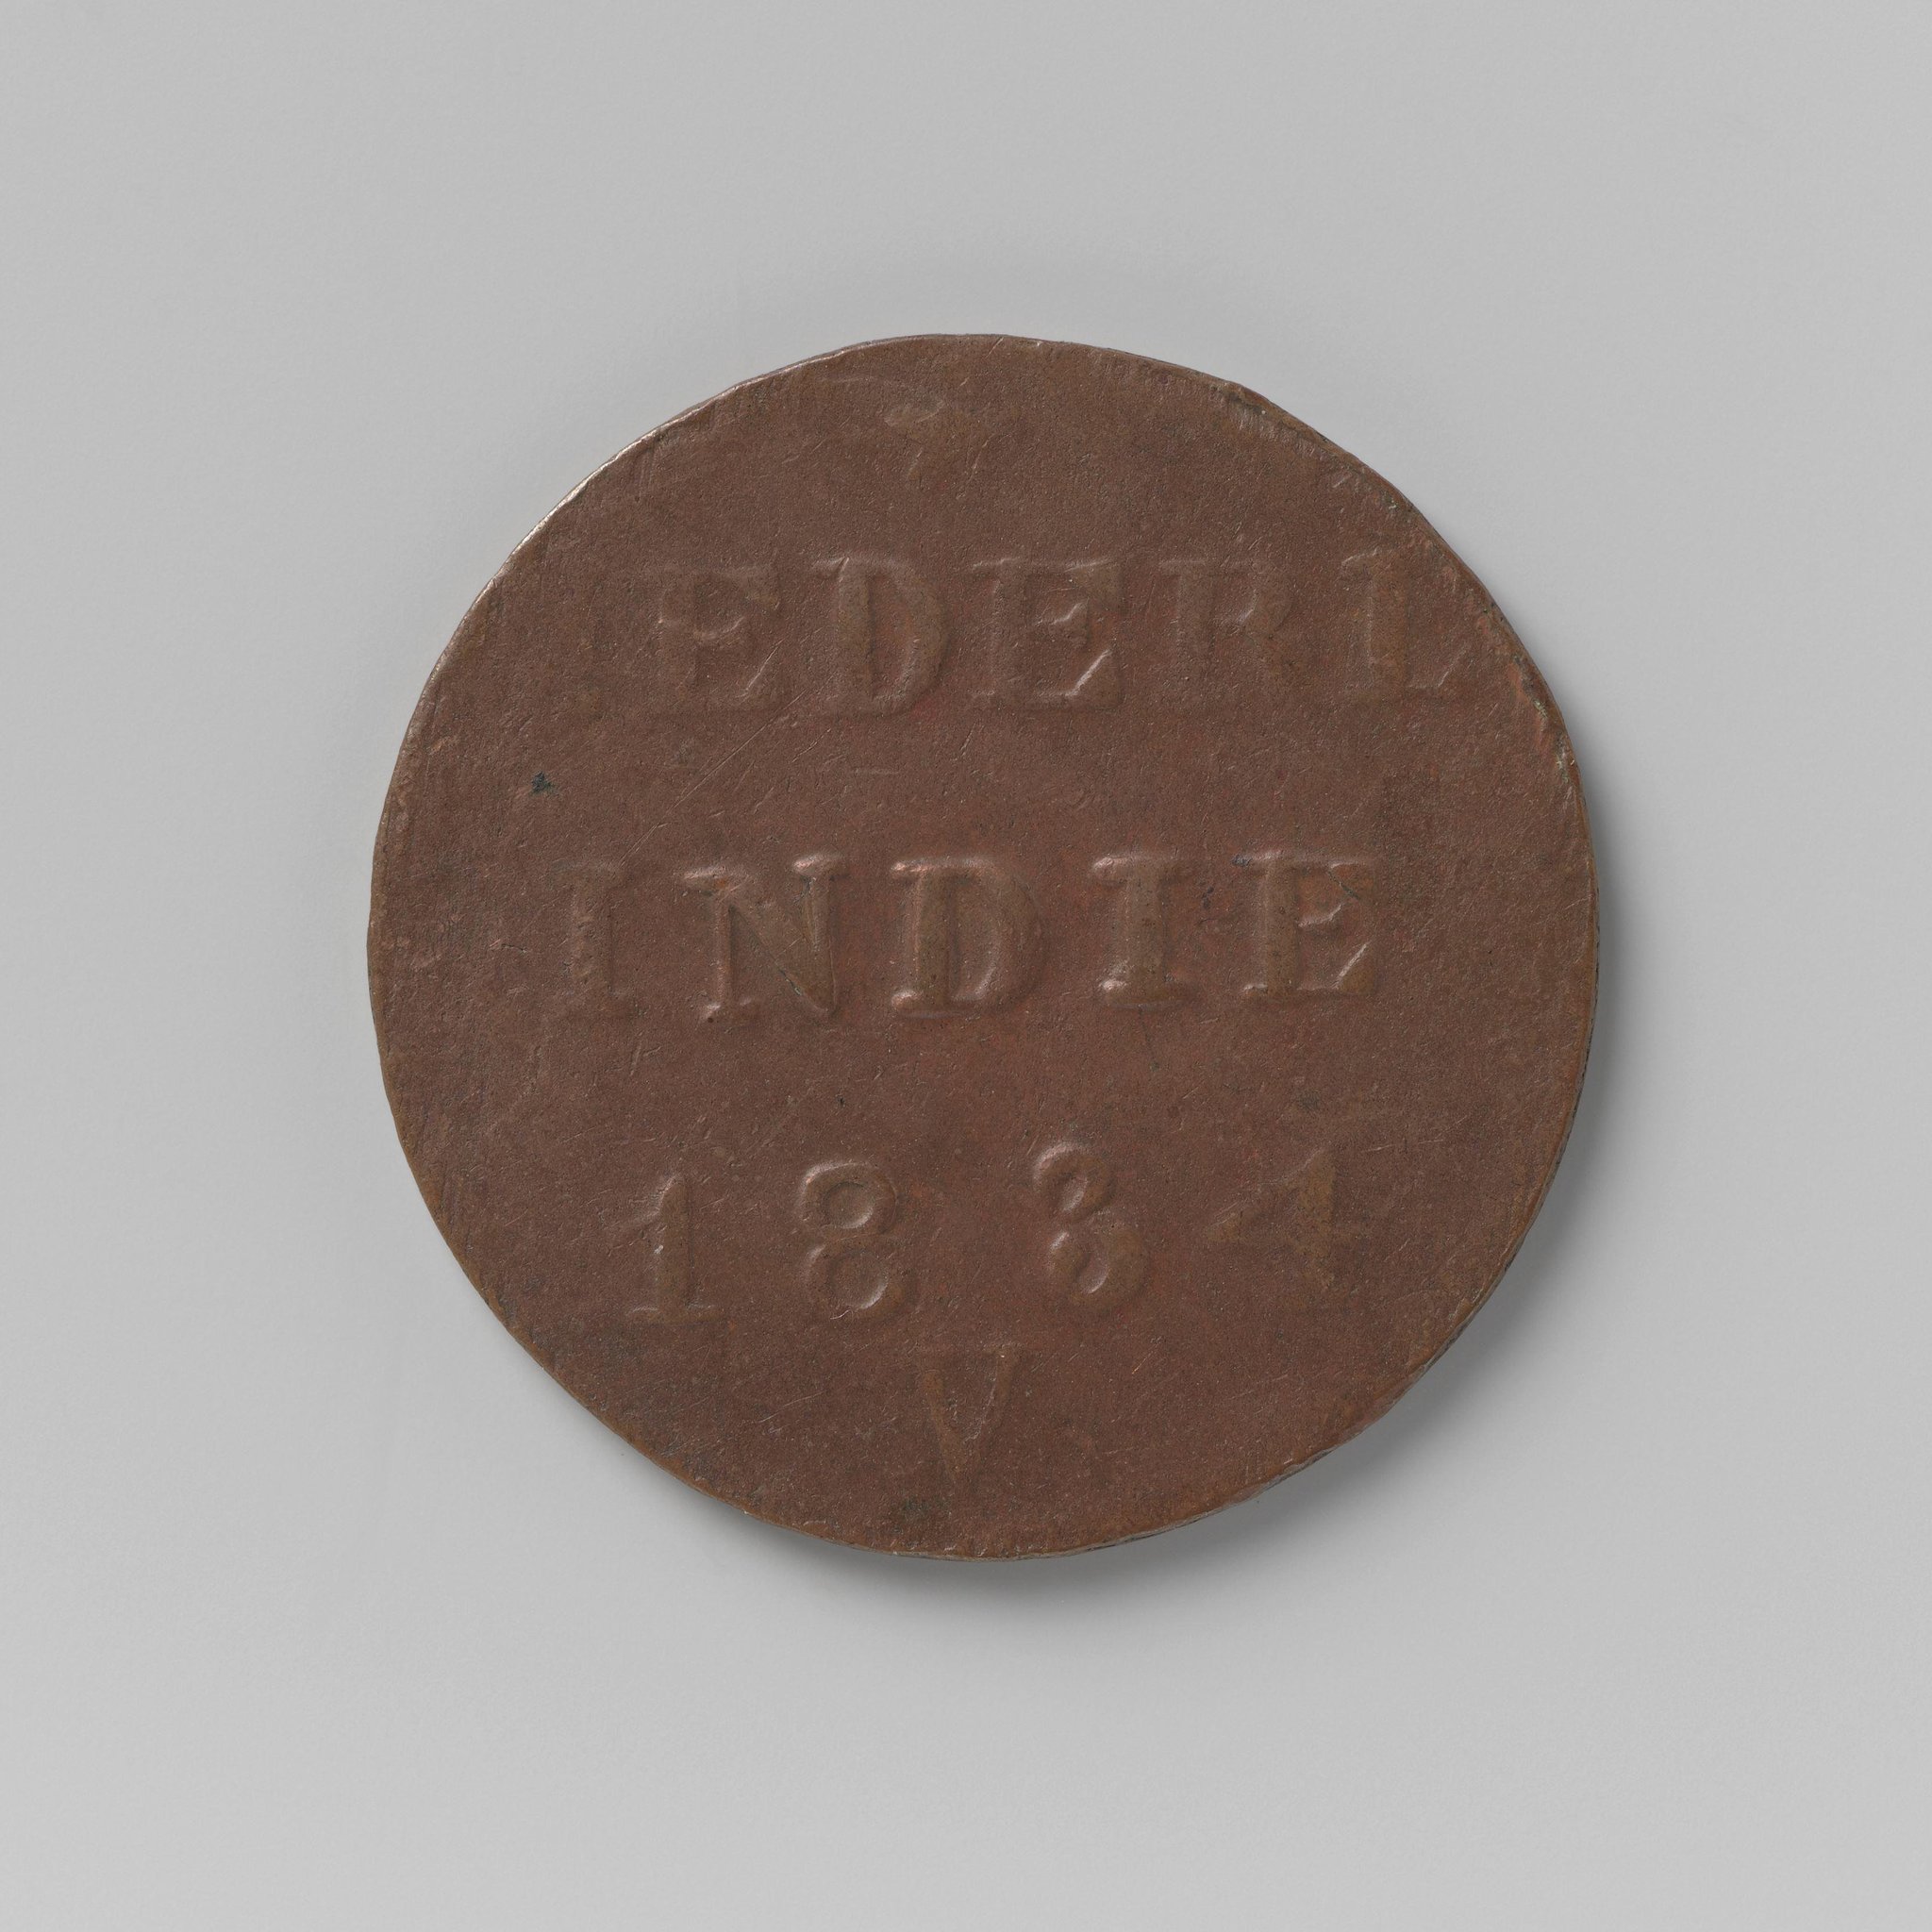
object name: coin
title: Nederlands Indië, cent,1834 V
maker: william i of the netherlands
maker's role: koning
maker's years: 1772-1843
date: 1834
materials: copper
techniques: striking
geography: surabaya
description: Koperen munt. Voorzijde: tussen waarde-aanduiding I CT. gekroond rijkswapenschild. Keerzijde: tweeregelig opschrift, waarboven muntteken en waaronder jaartal. Daaronder letter V [=muntmeester De Vogel]. Gladde rand.